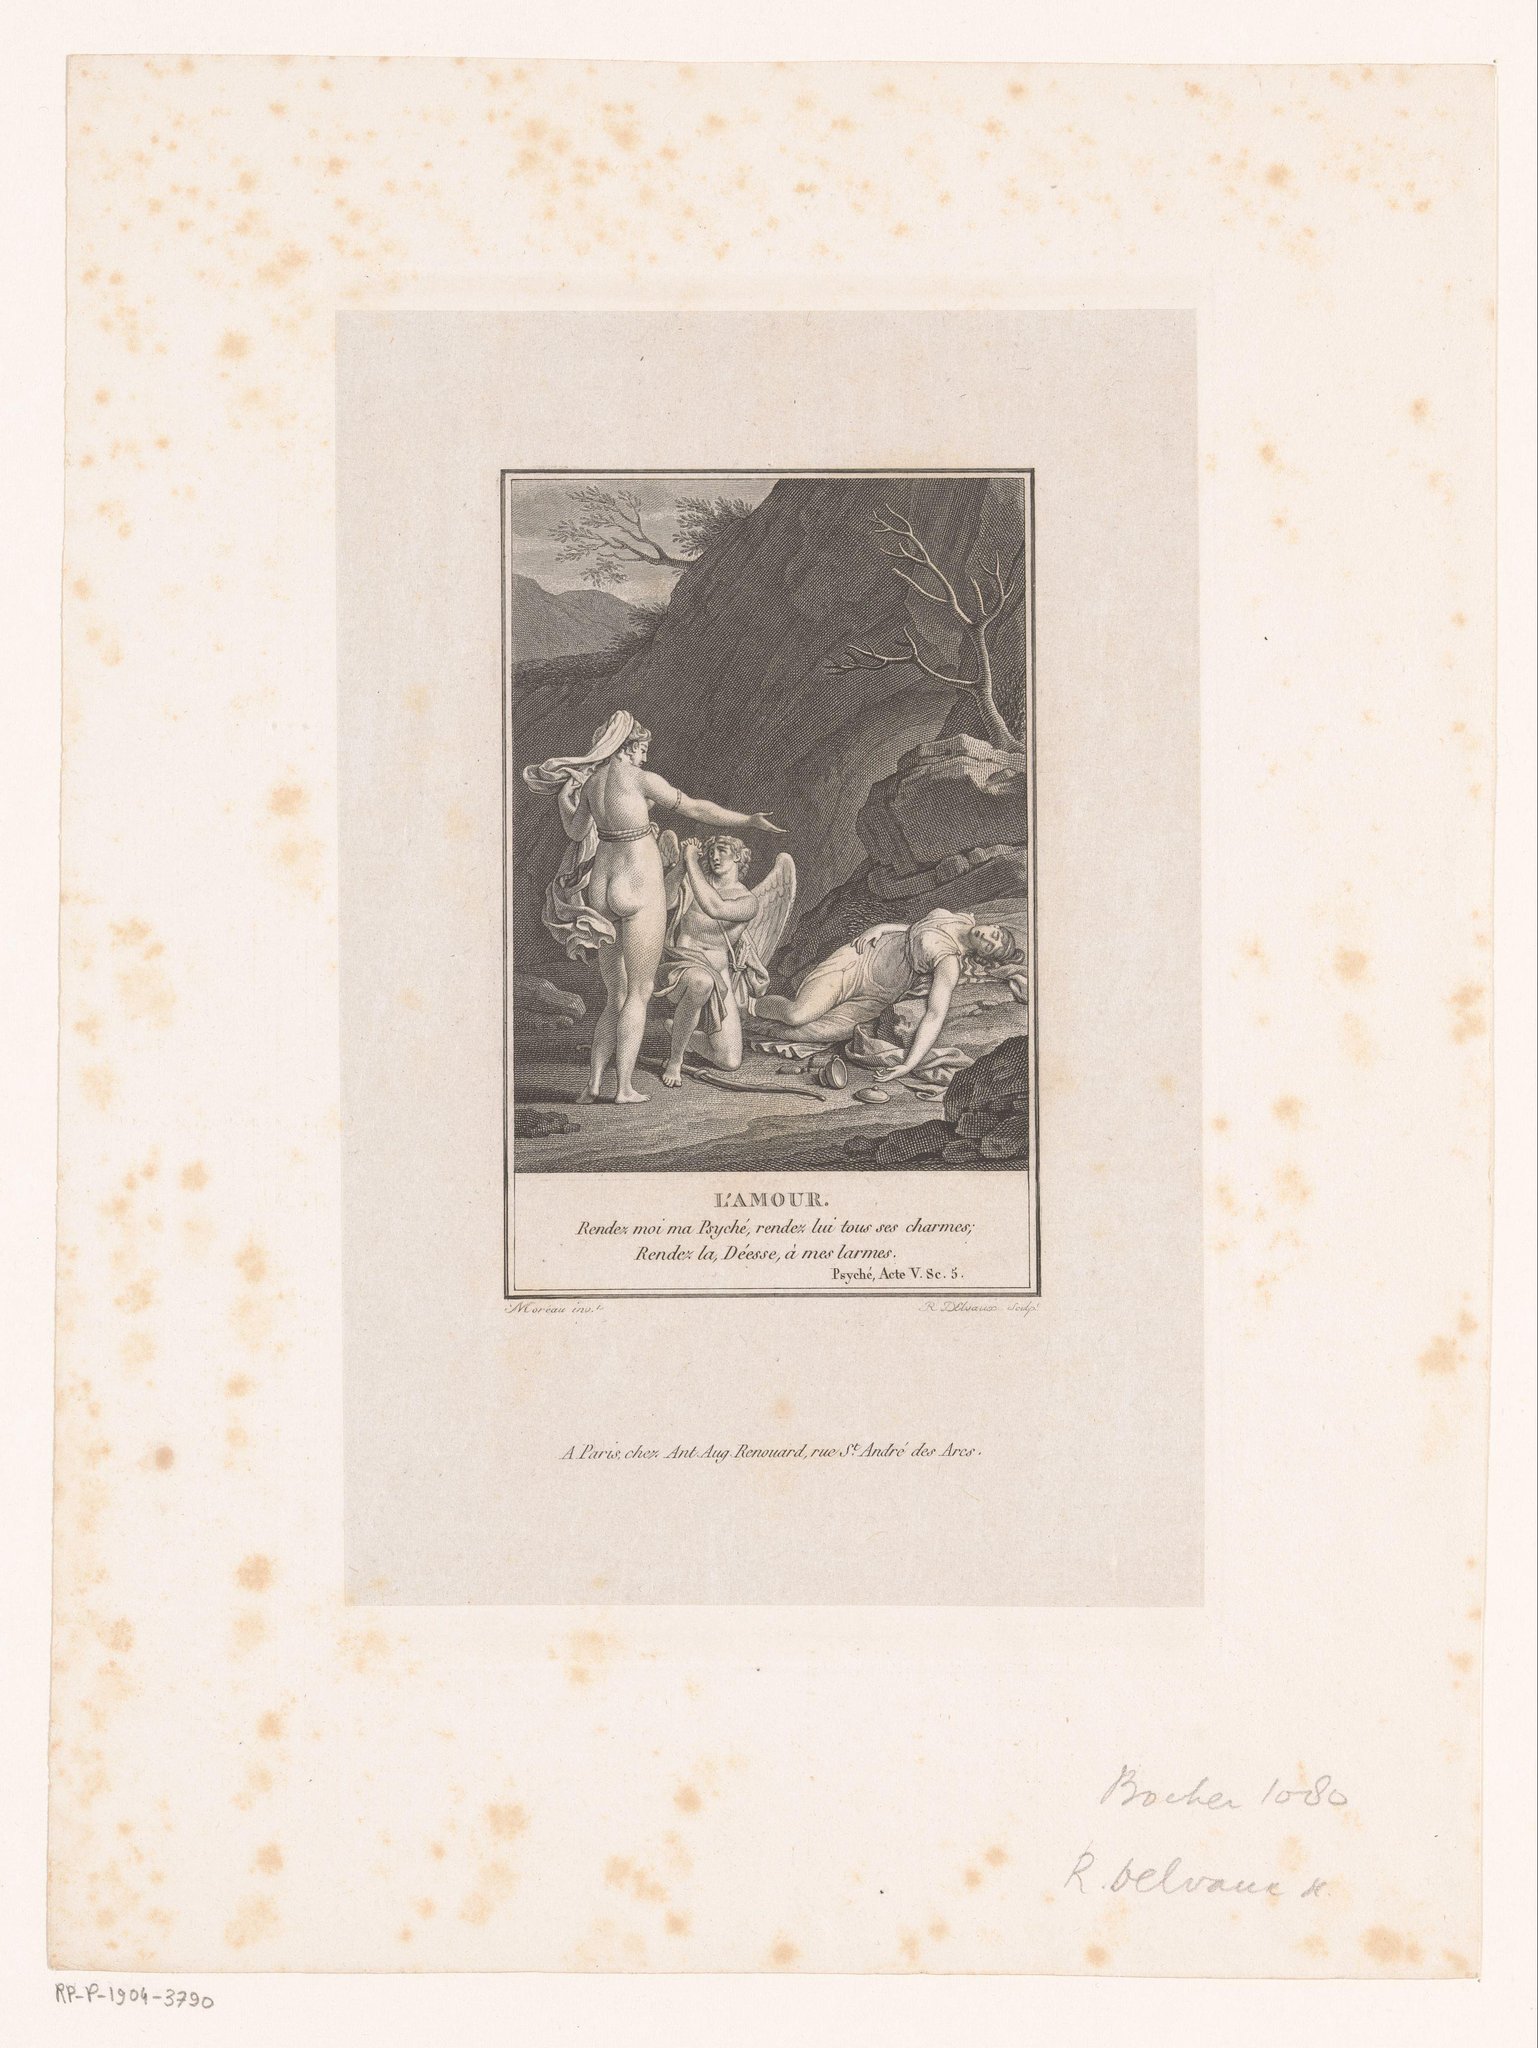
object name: book illustration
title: Amor en Psyche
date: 1811-1813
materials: paper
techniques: engraving, etching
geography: paris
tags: psyche, theatre, theatrical performance, psyche, on her way back, opens proserpina's casket and is overcome by sleep, (story of) cupid, amor (eros)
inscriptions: collector's mark: Lugt 2228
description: Prent van scène vijf uit de vijfde acte van 'Psyché' door Jean Baptiste Molière. Dit betreft een van de dertig prenten, gemaakt in opdracht van Antoine Augustin Renouard, bestemd voor verschillende edities van Molières werk daterend van 1811 tot 1813. De prenten zijn vervaardigd door verschillende kunstenaars naar composities van Moreau.